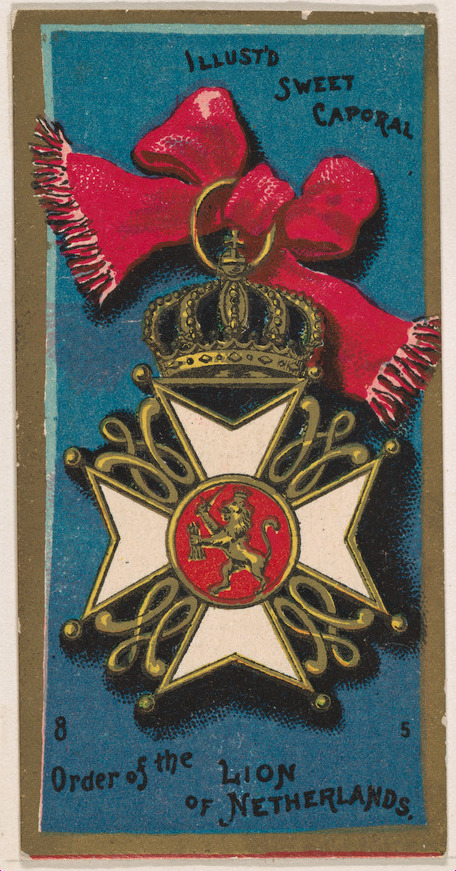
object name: print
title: Order of the Lion of Netherlands, from the Military Series (N224) issued by Kinney Tobacco Company to promote Sweet Caporal Cigarettes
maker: kinney brothers tobacco company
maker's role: publisher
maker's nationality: american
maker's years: 1869-2011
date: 1888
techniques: color lithograph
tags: lions